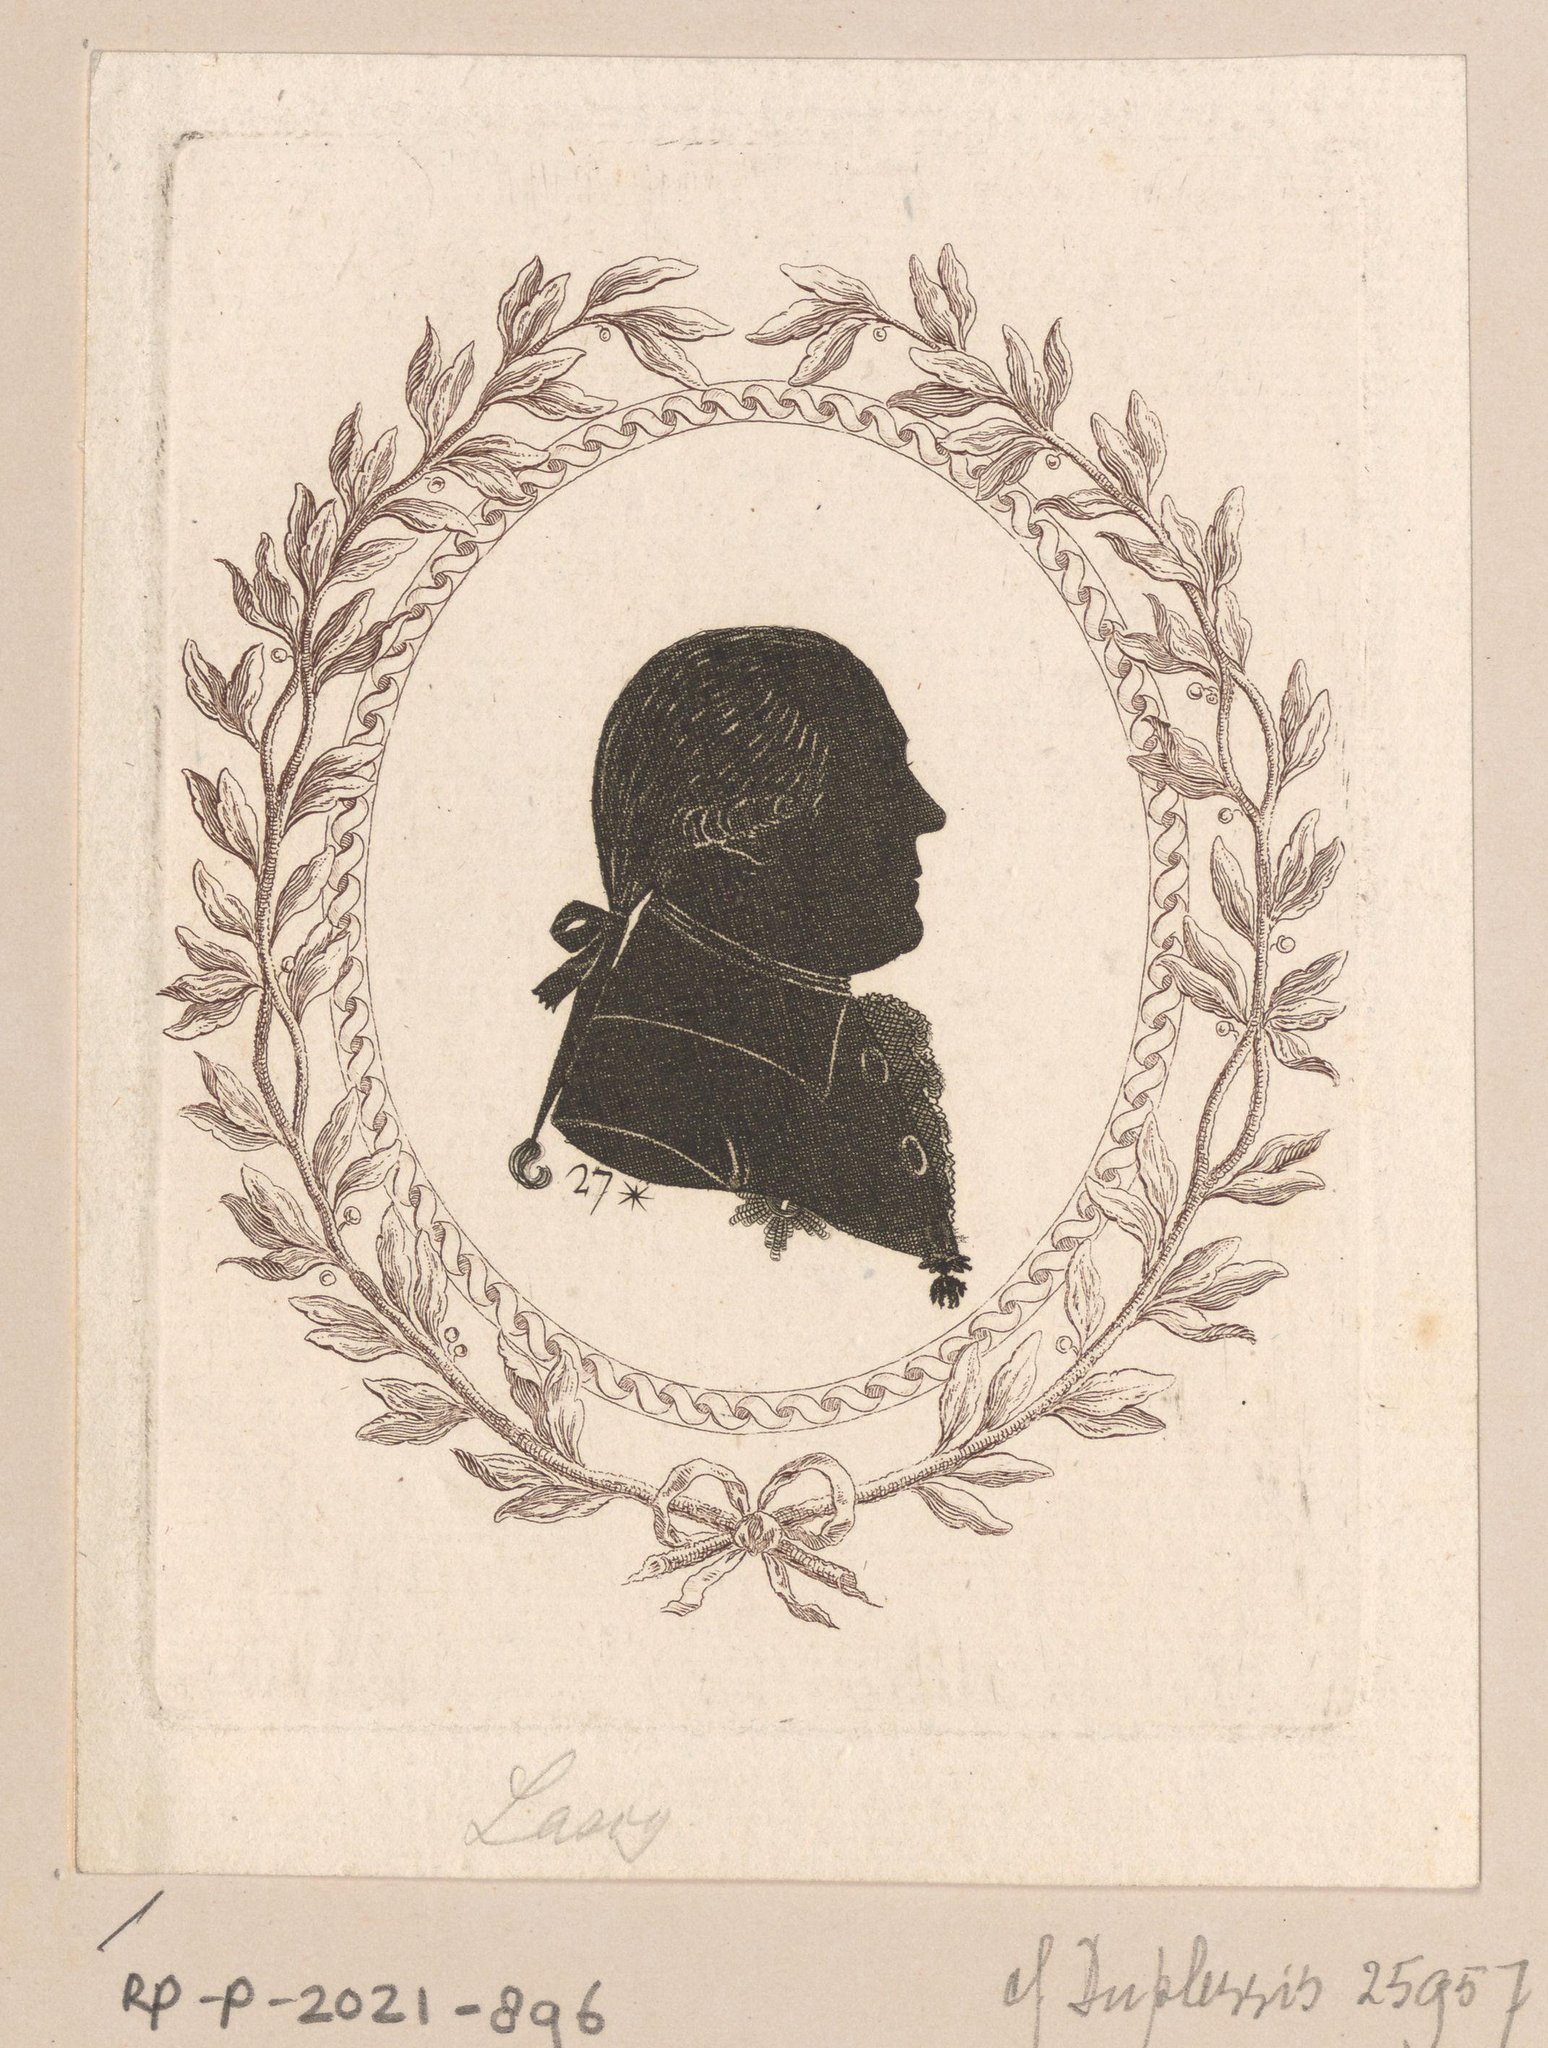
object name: print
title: Silhouetportret van Peter Lacy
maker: Anonymous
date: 1750-1850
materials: paper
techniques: etching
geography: england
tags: commander-in-chief, general, marshal, historical persons, knighthood order of the golden fleece - insignia of a knighthood order, e.g.: badge, chain (with name of order)